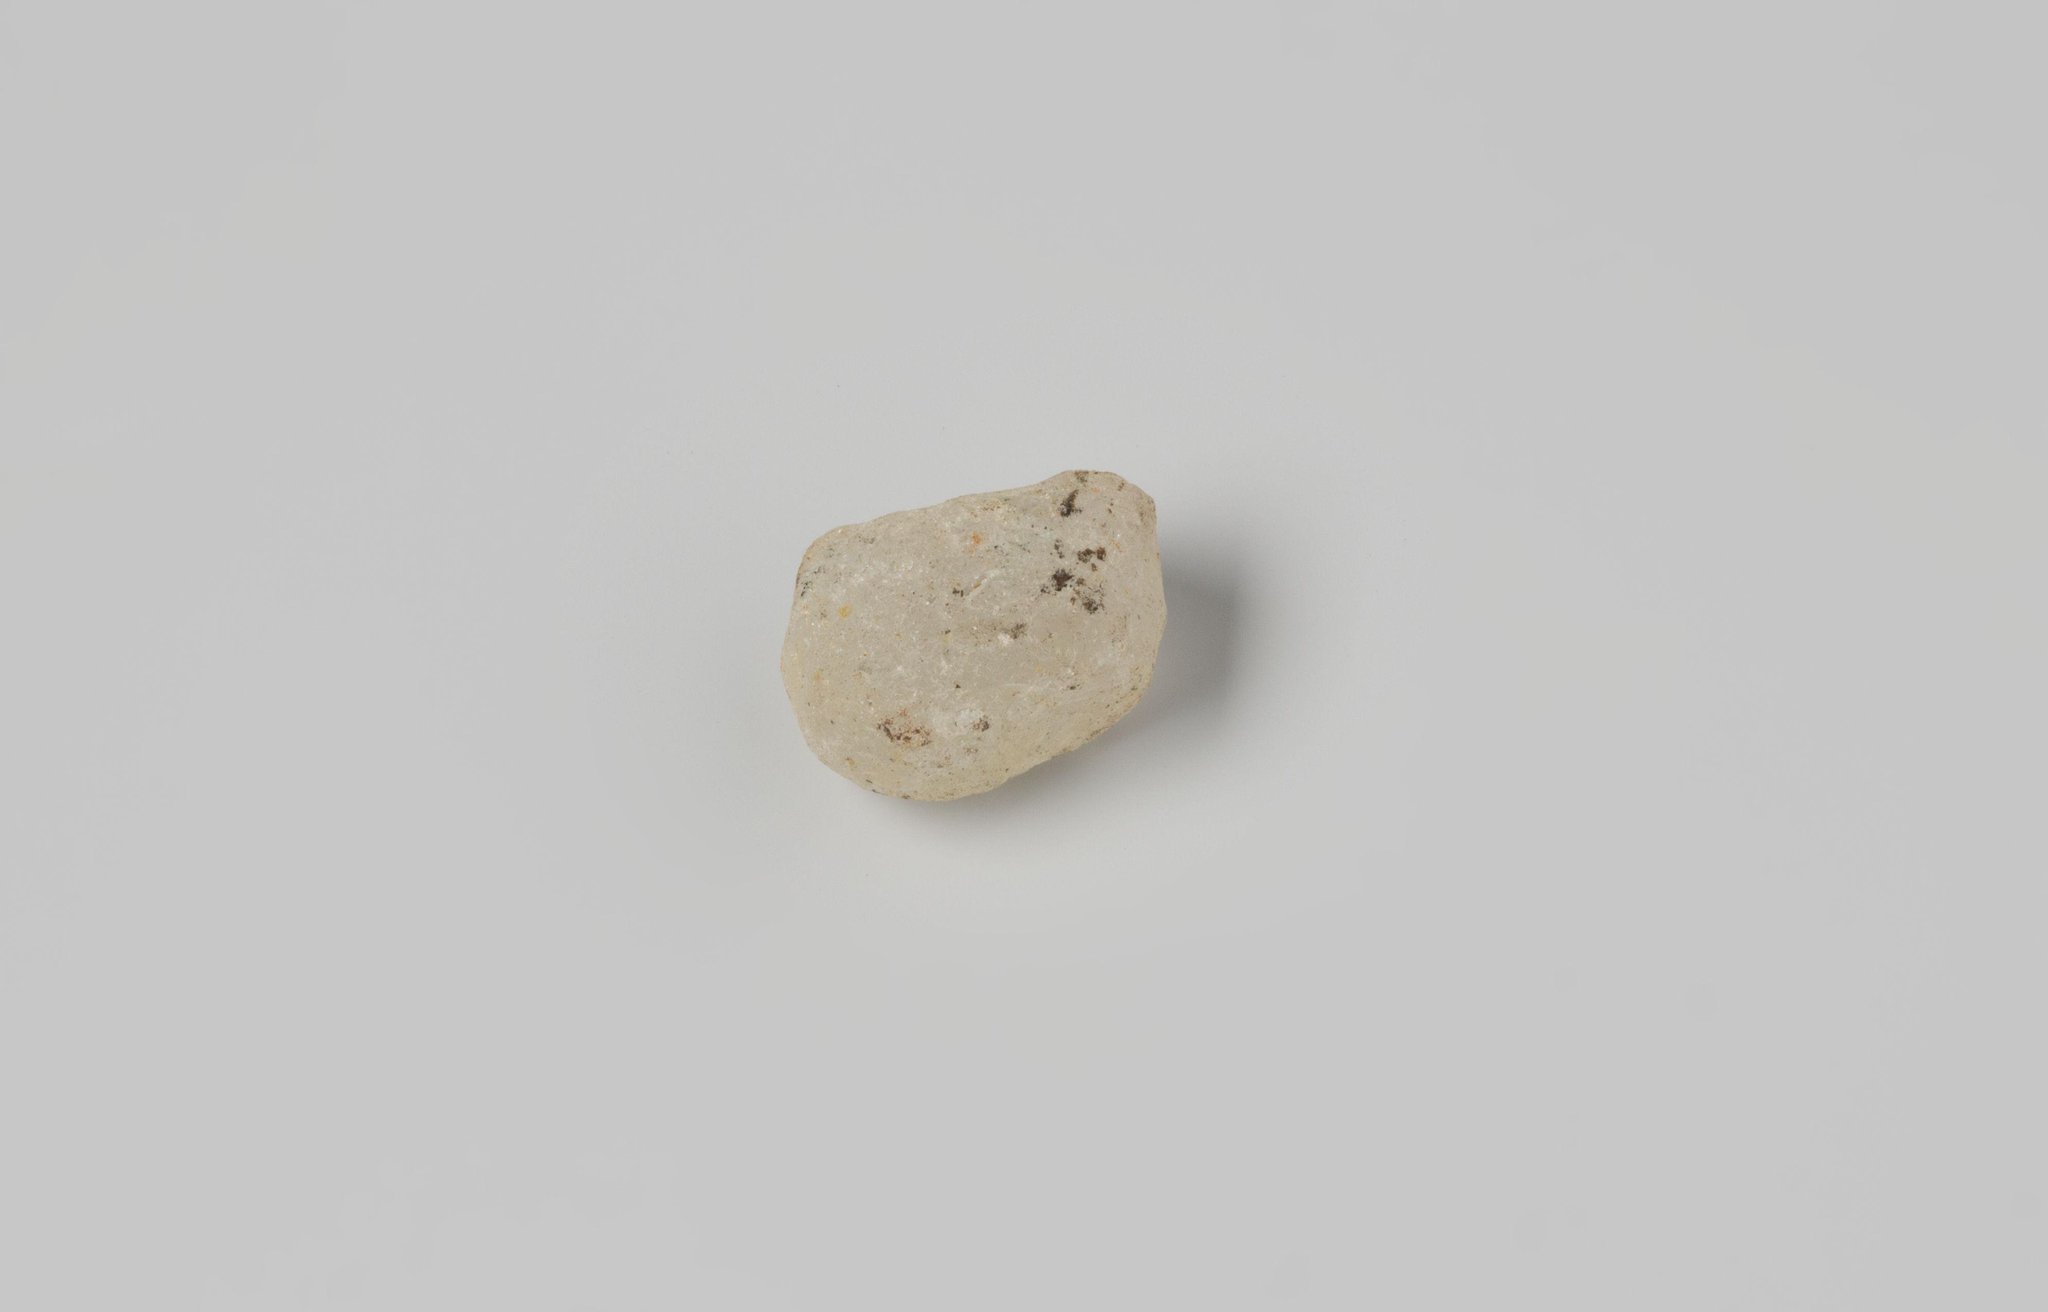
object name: scheepswrakvondst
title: Fragment glas uit het wrak van de Oost-Indiëvaarder Hollandia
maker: Anonymous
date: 1700-1743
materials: glass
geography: netherlands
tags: verenigde oostindische compagnie, hollandia (schip), annet